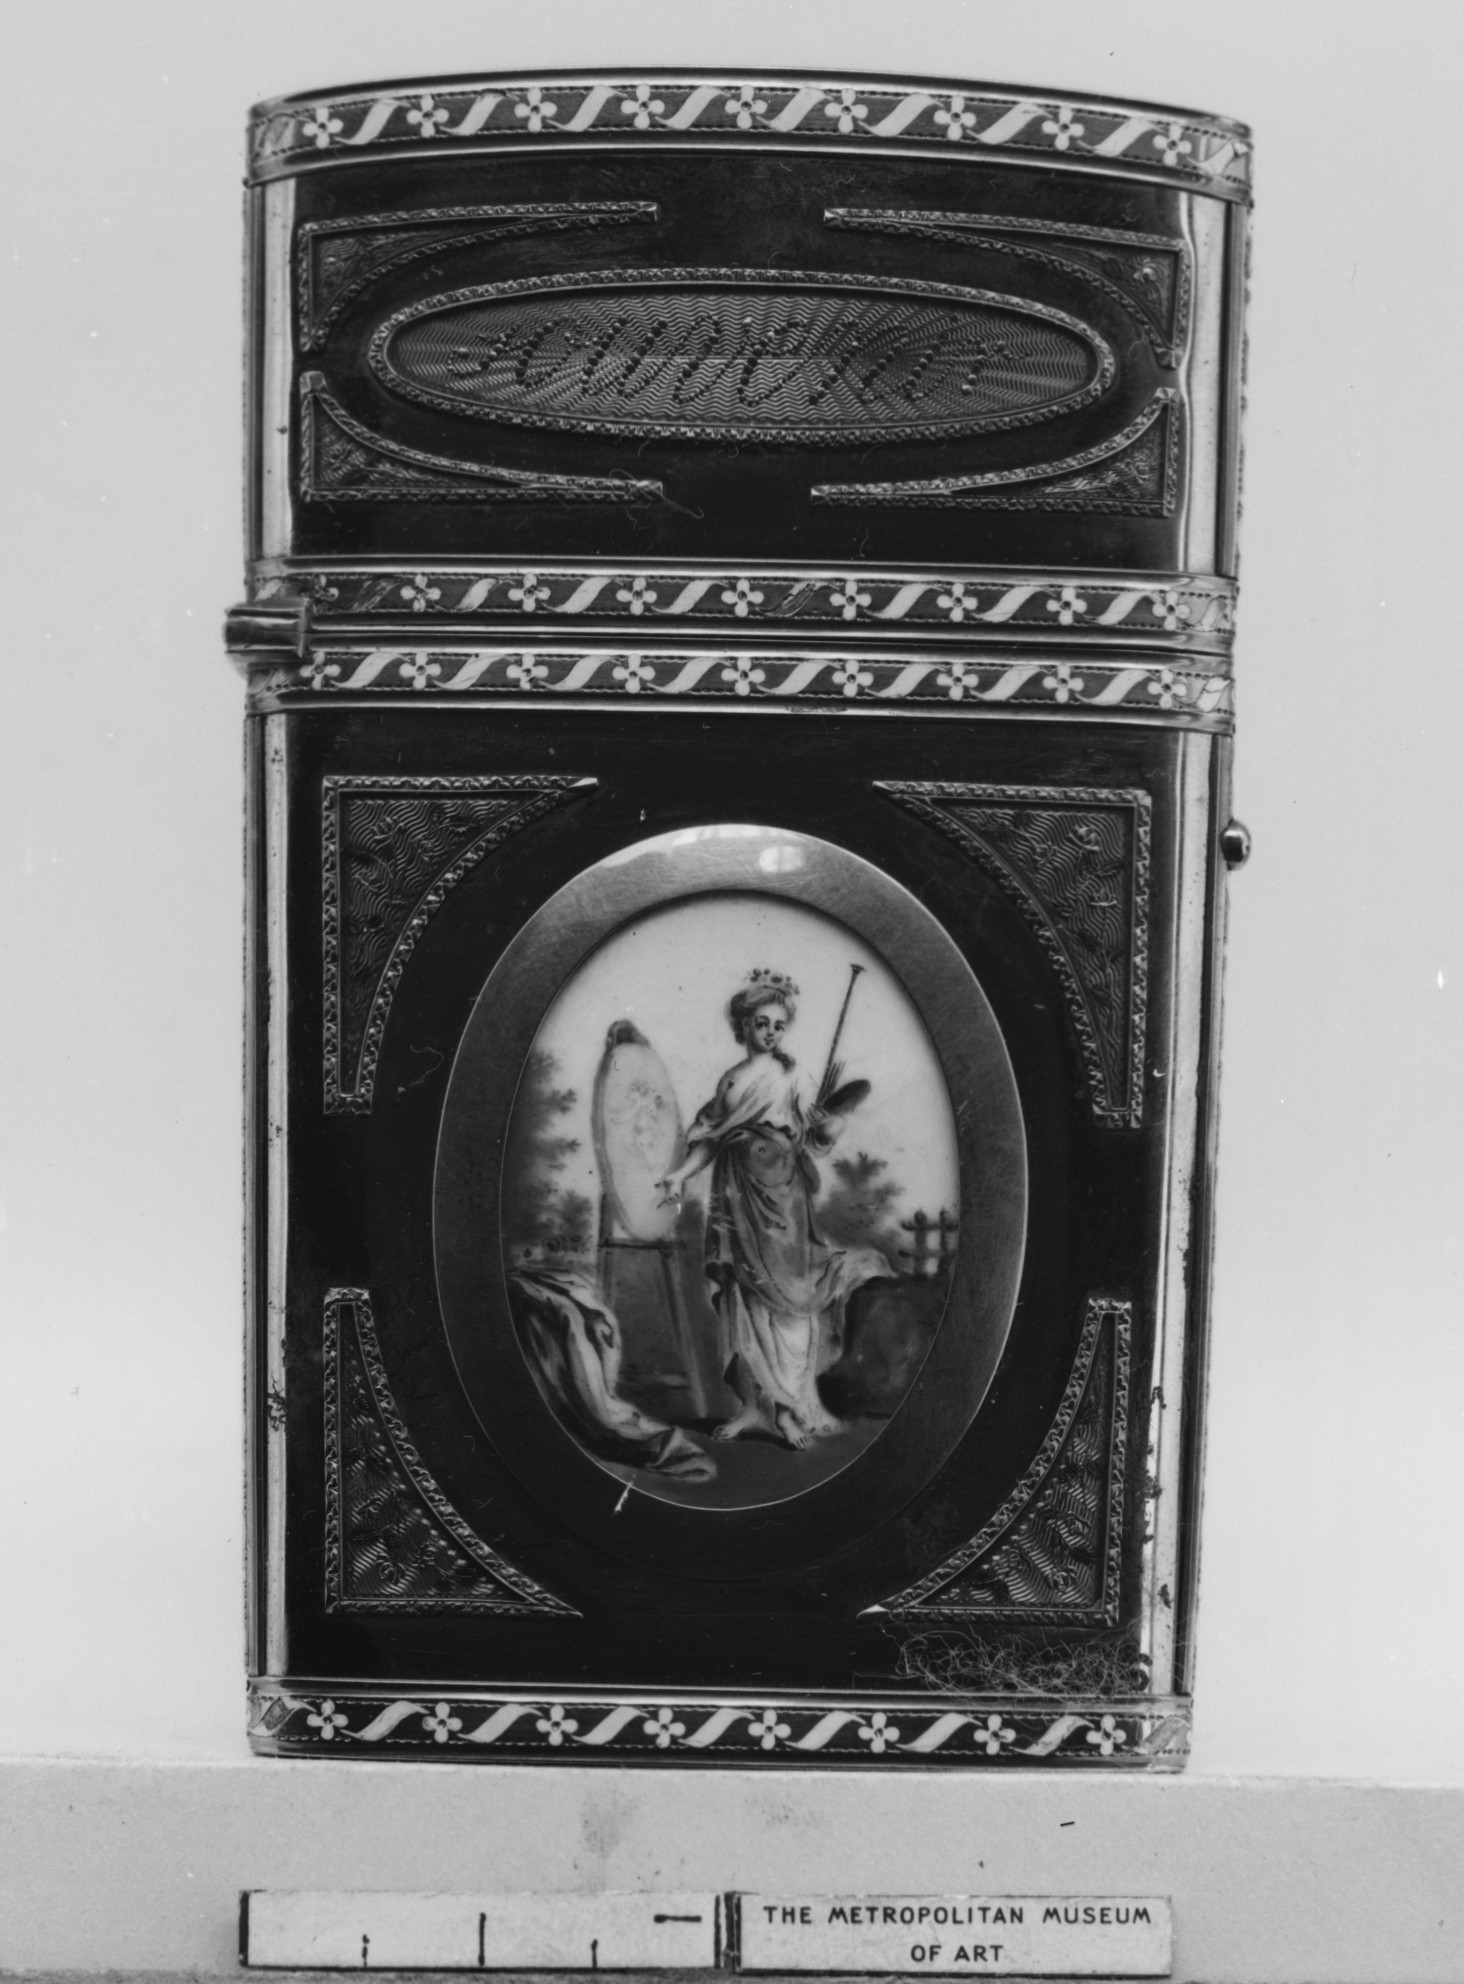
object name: souvenir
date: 1867-1900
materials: enamel, gold, ivory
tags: women